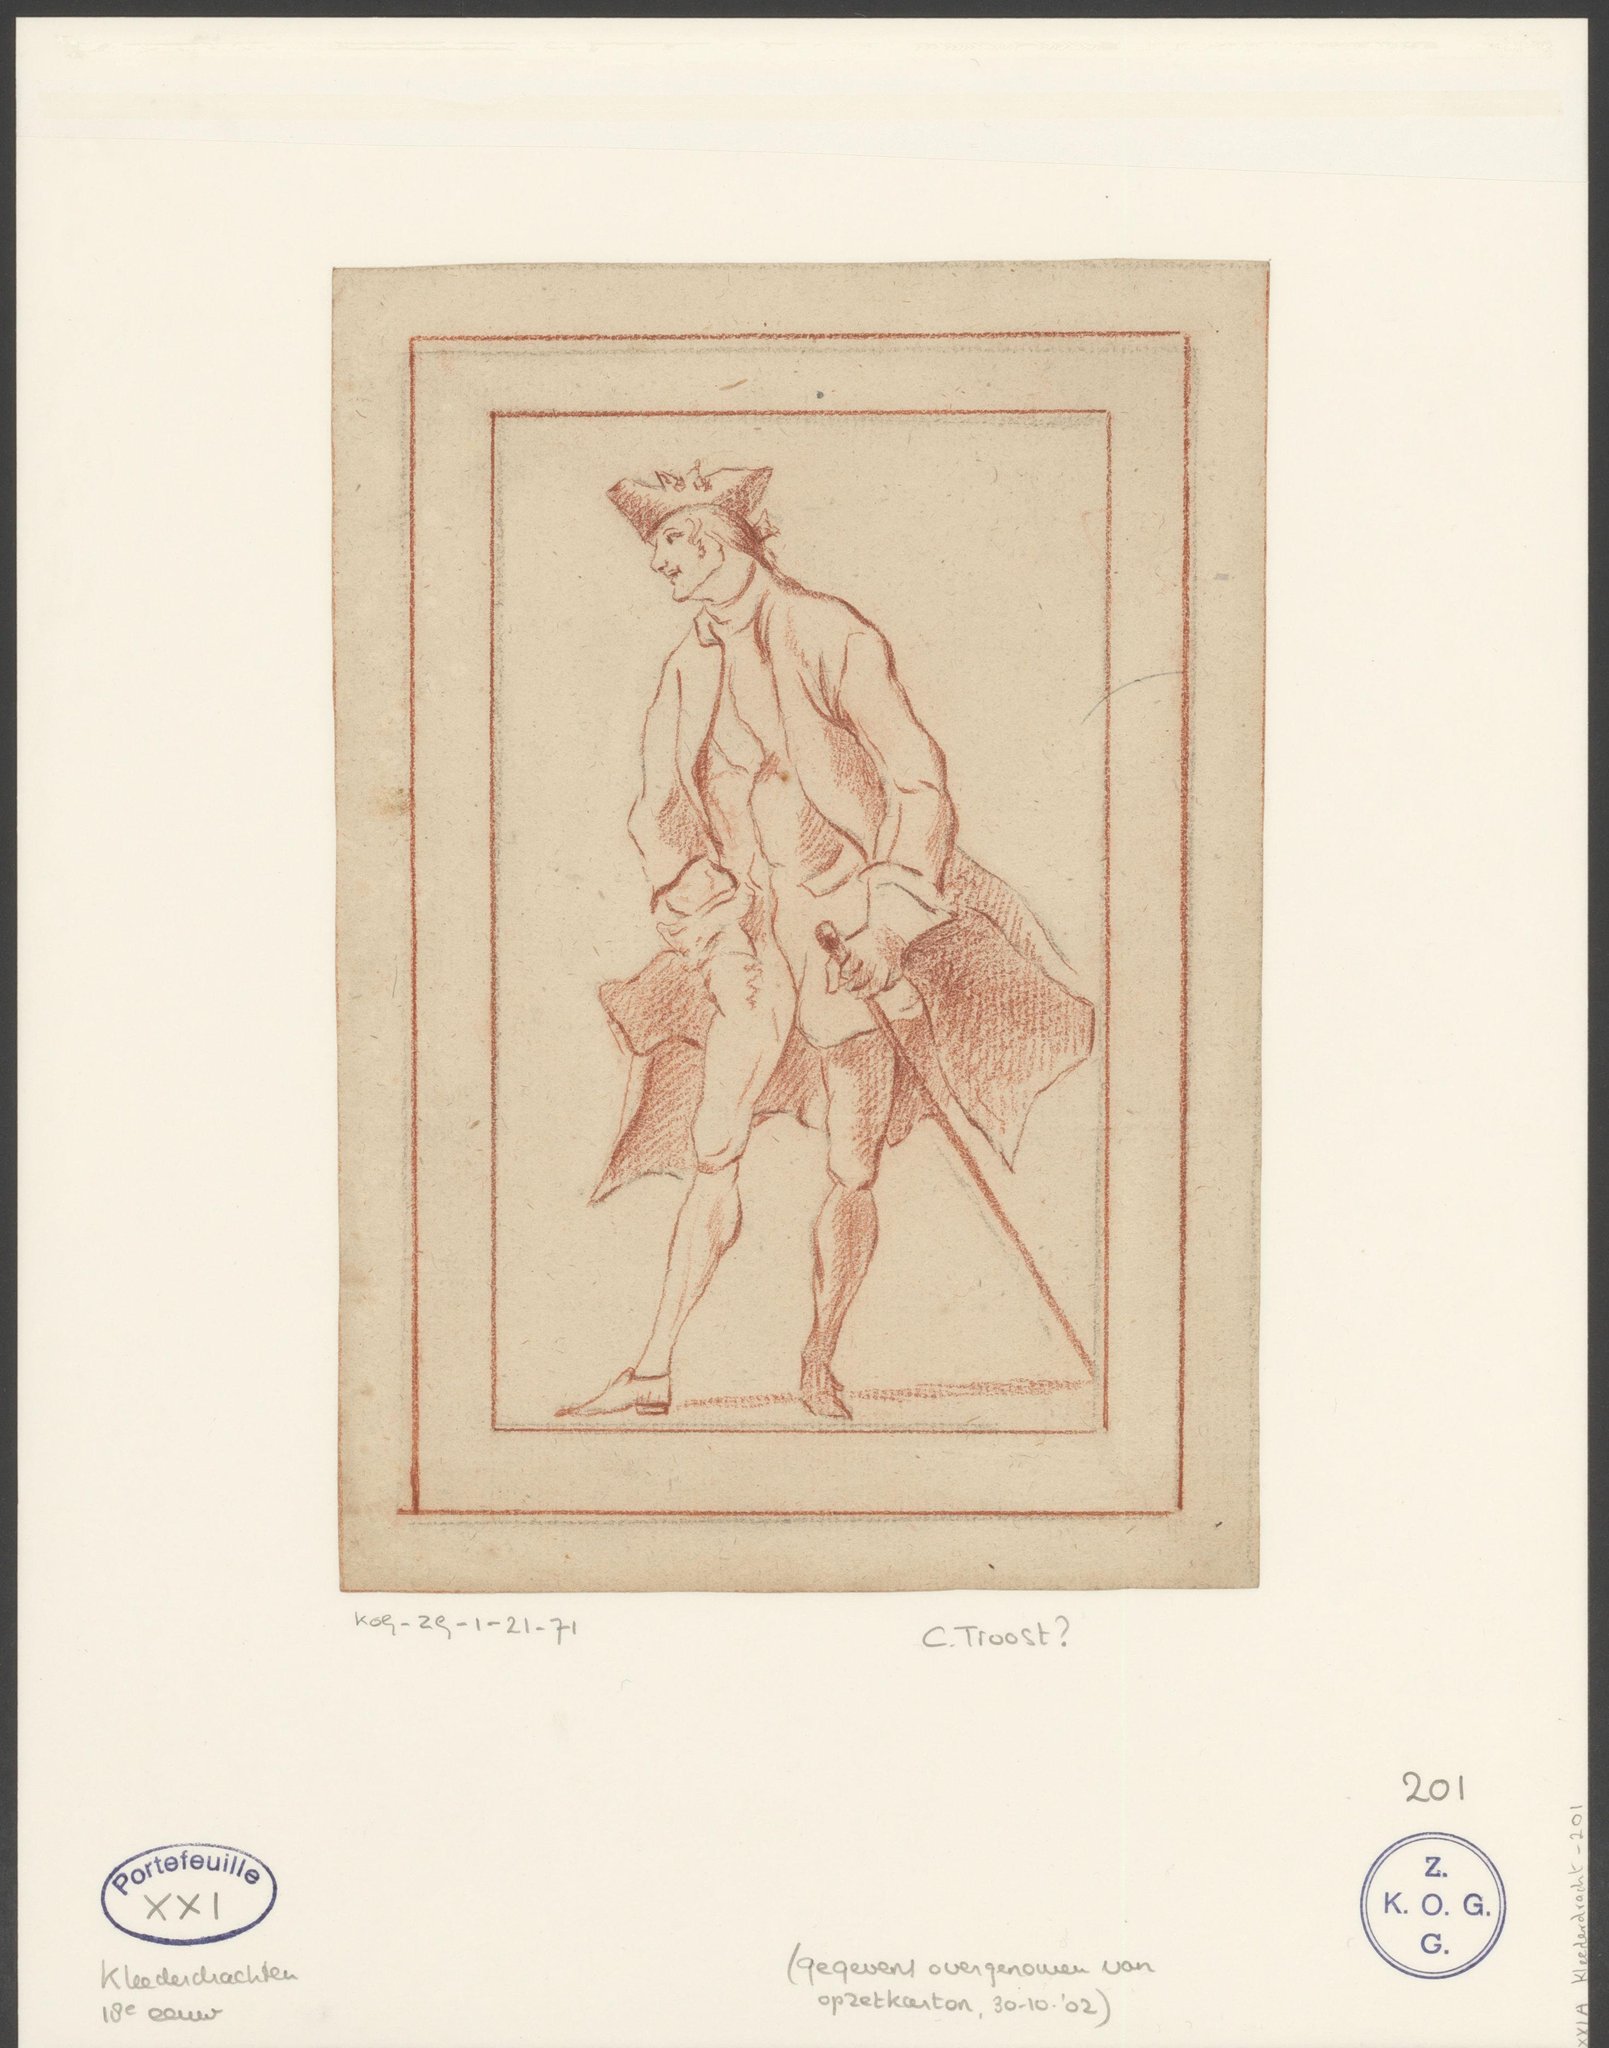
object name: drawing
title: Staande heer met steek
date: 1712-1750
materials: chalk, paper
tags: standing figure, head-gear: tricorn, youth, adolescent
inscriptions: collector's mark: Lugt 1641, stamp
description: Onderwerpsrubrieken binnen de Atlas Zeden en Gewoonten: Zeden en Gewoonten in Engeren Zin, De Kleeding, Kleederdrachten (tijdvakken), De 18de eeuw (de pruikentijd). Mannen en vrouwen.